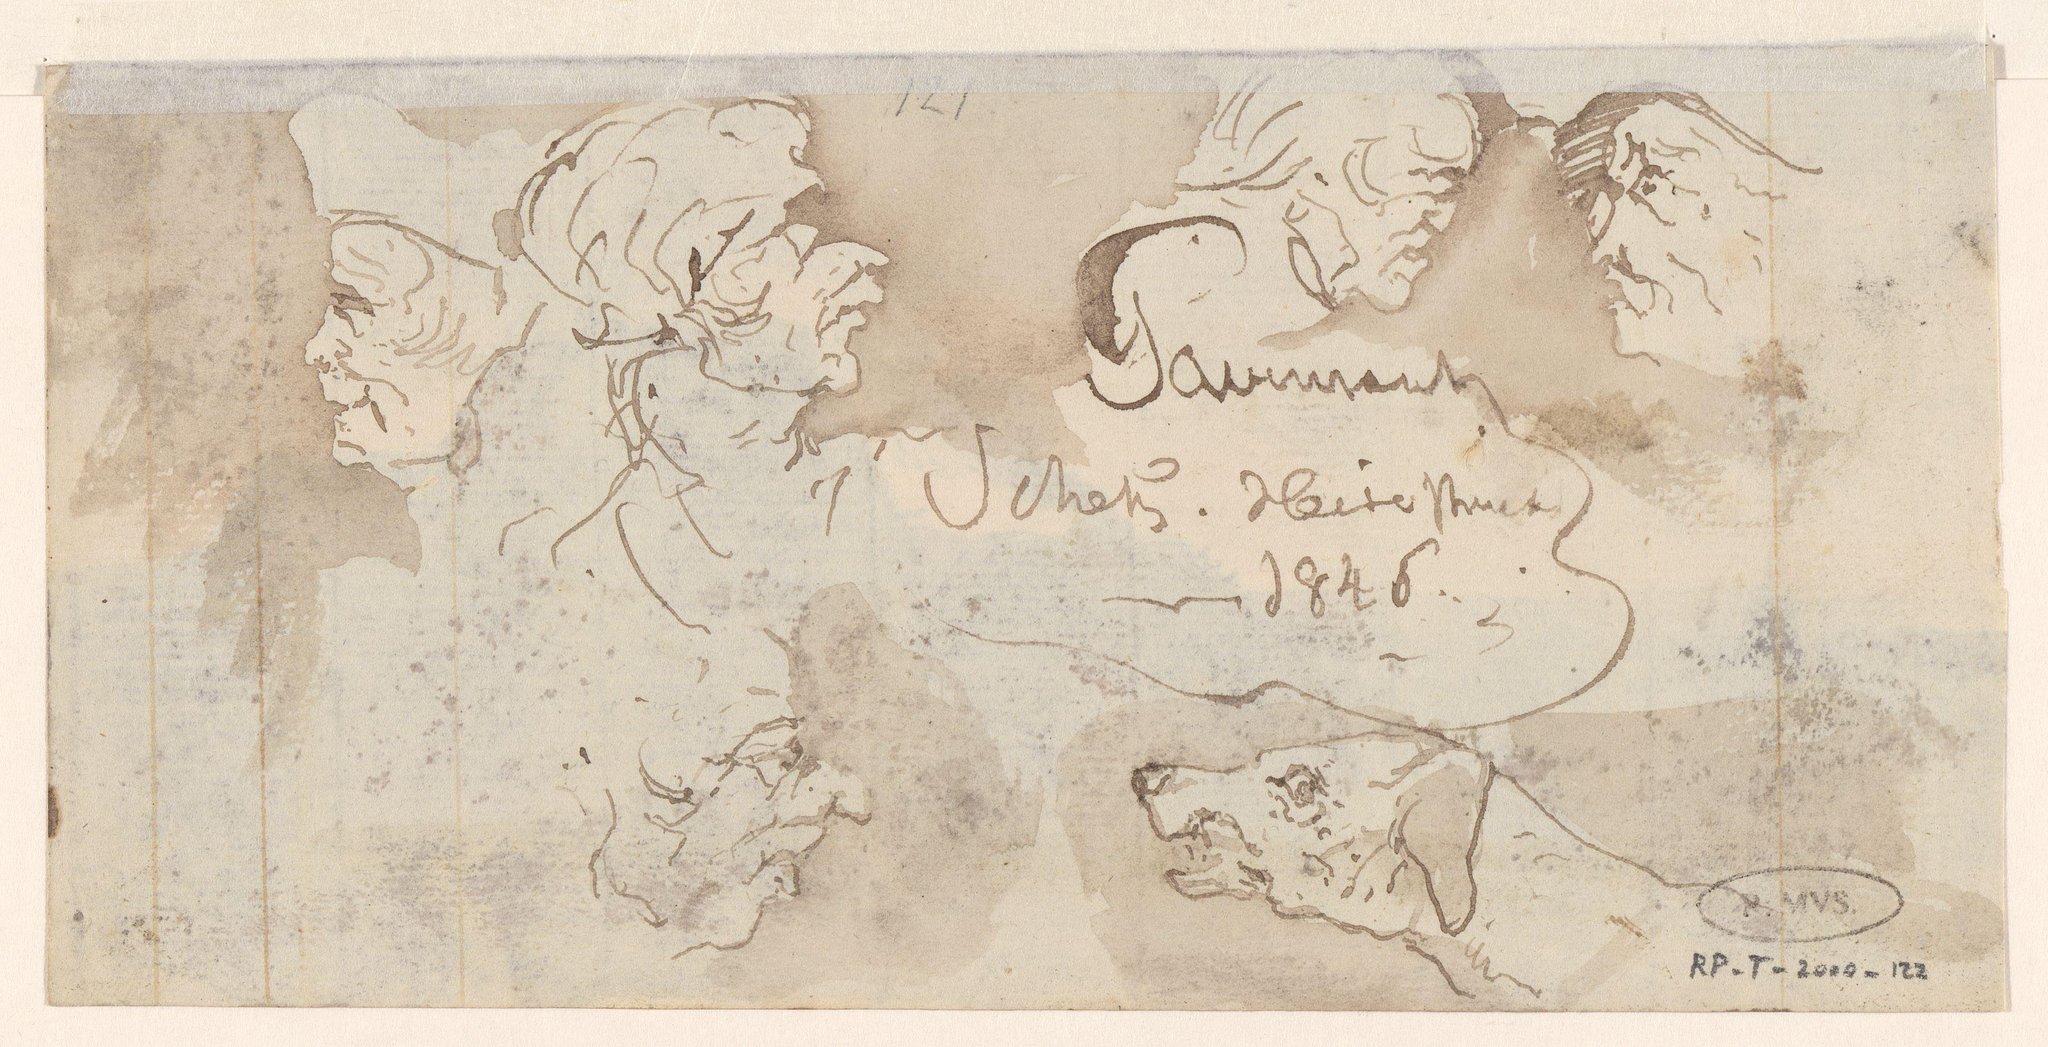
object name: drawing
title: Koppen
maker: johannes tavenraat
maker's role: draughtsman, painter, print maker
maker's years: 1809-1881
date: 1846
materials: ink, paper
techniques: brush, pen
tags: hunting dogs, hunter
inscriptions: signature and date: ‘Tavenraat / Schets ... 1846’, collector's mark: Lugt 2228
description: Schetsen van koppen van jagers en een hond.